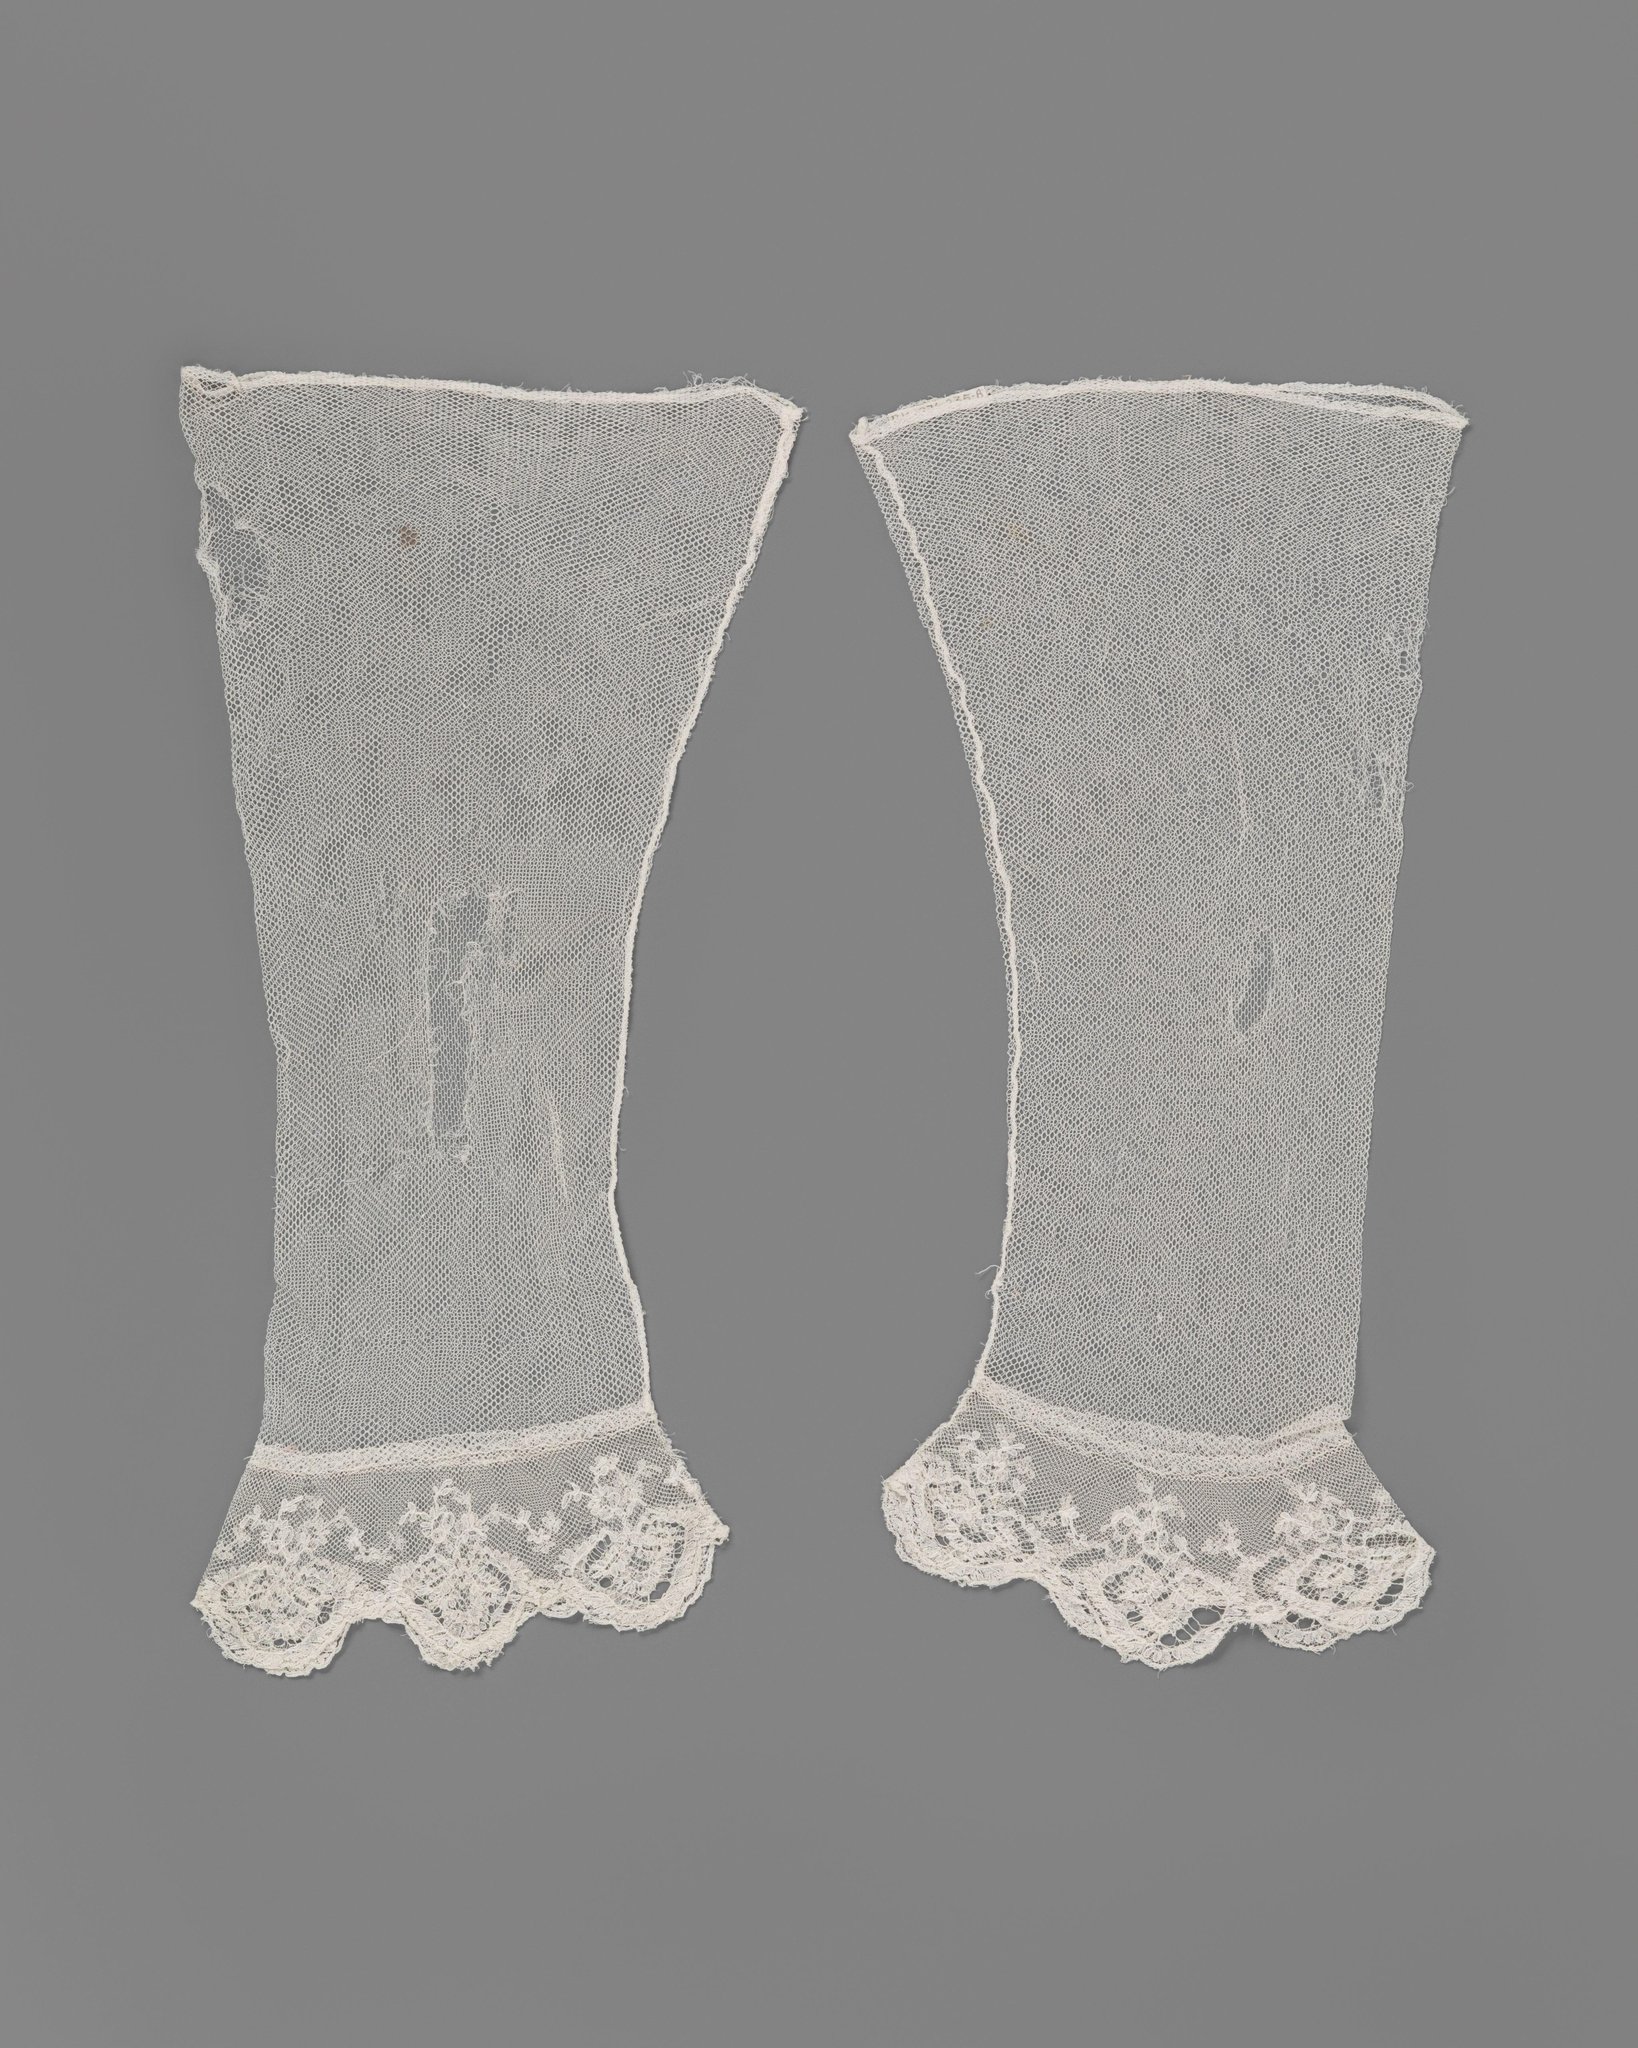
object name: womenswear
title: Ondermouw van tule met kanten boord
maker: Anonymous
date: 1935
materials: lace, fiber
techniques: lace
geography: western europe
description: Ondermouw van tule en kant. Glad model mouw waaraan aangezet een afhangende machinale geschulpte strook kant, versierd met bloemen.